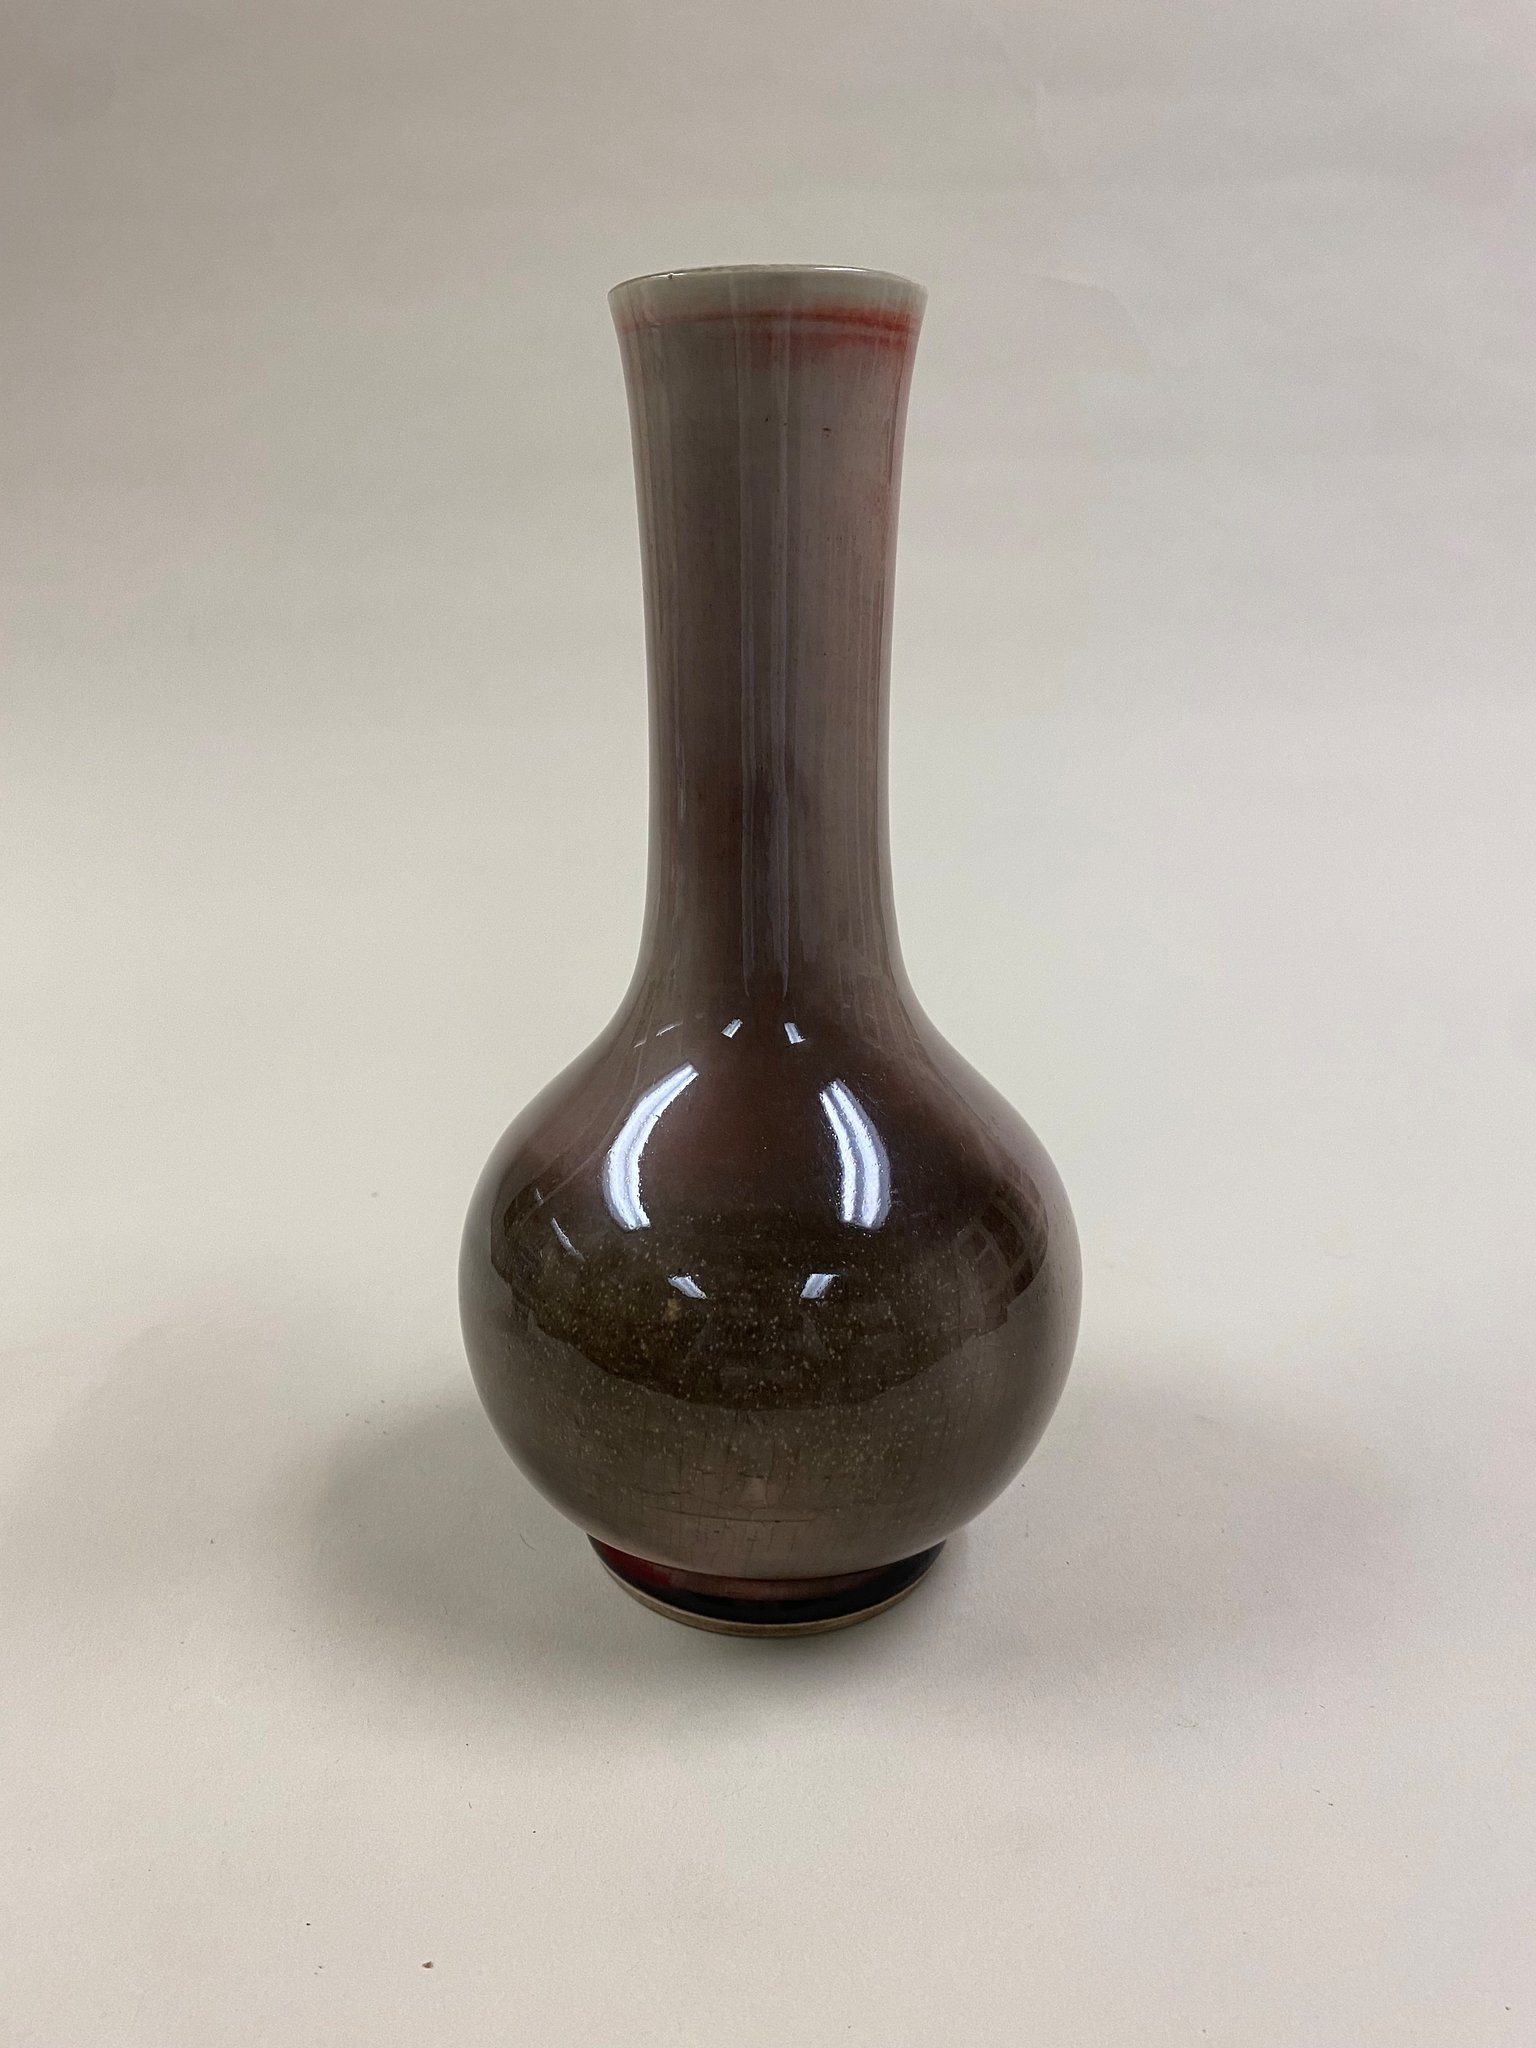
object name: vase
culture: chinese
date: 1667-1733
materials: copper, glaze, porcelain